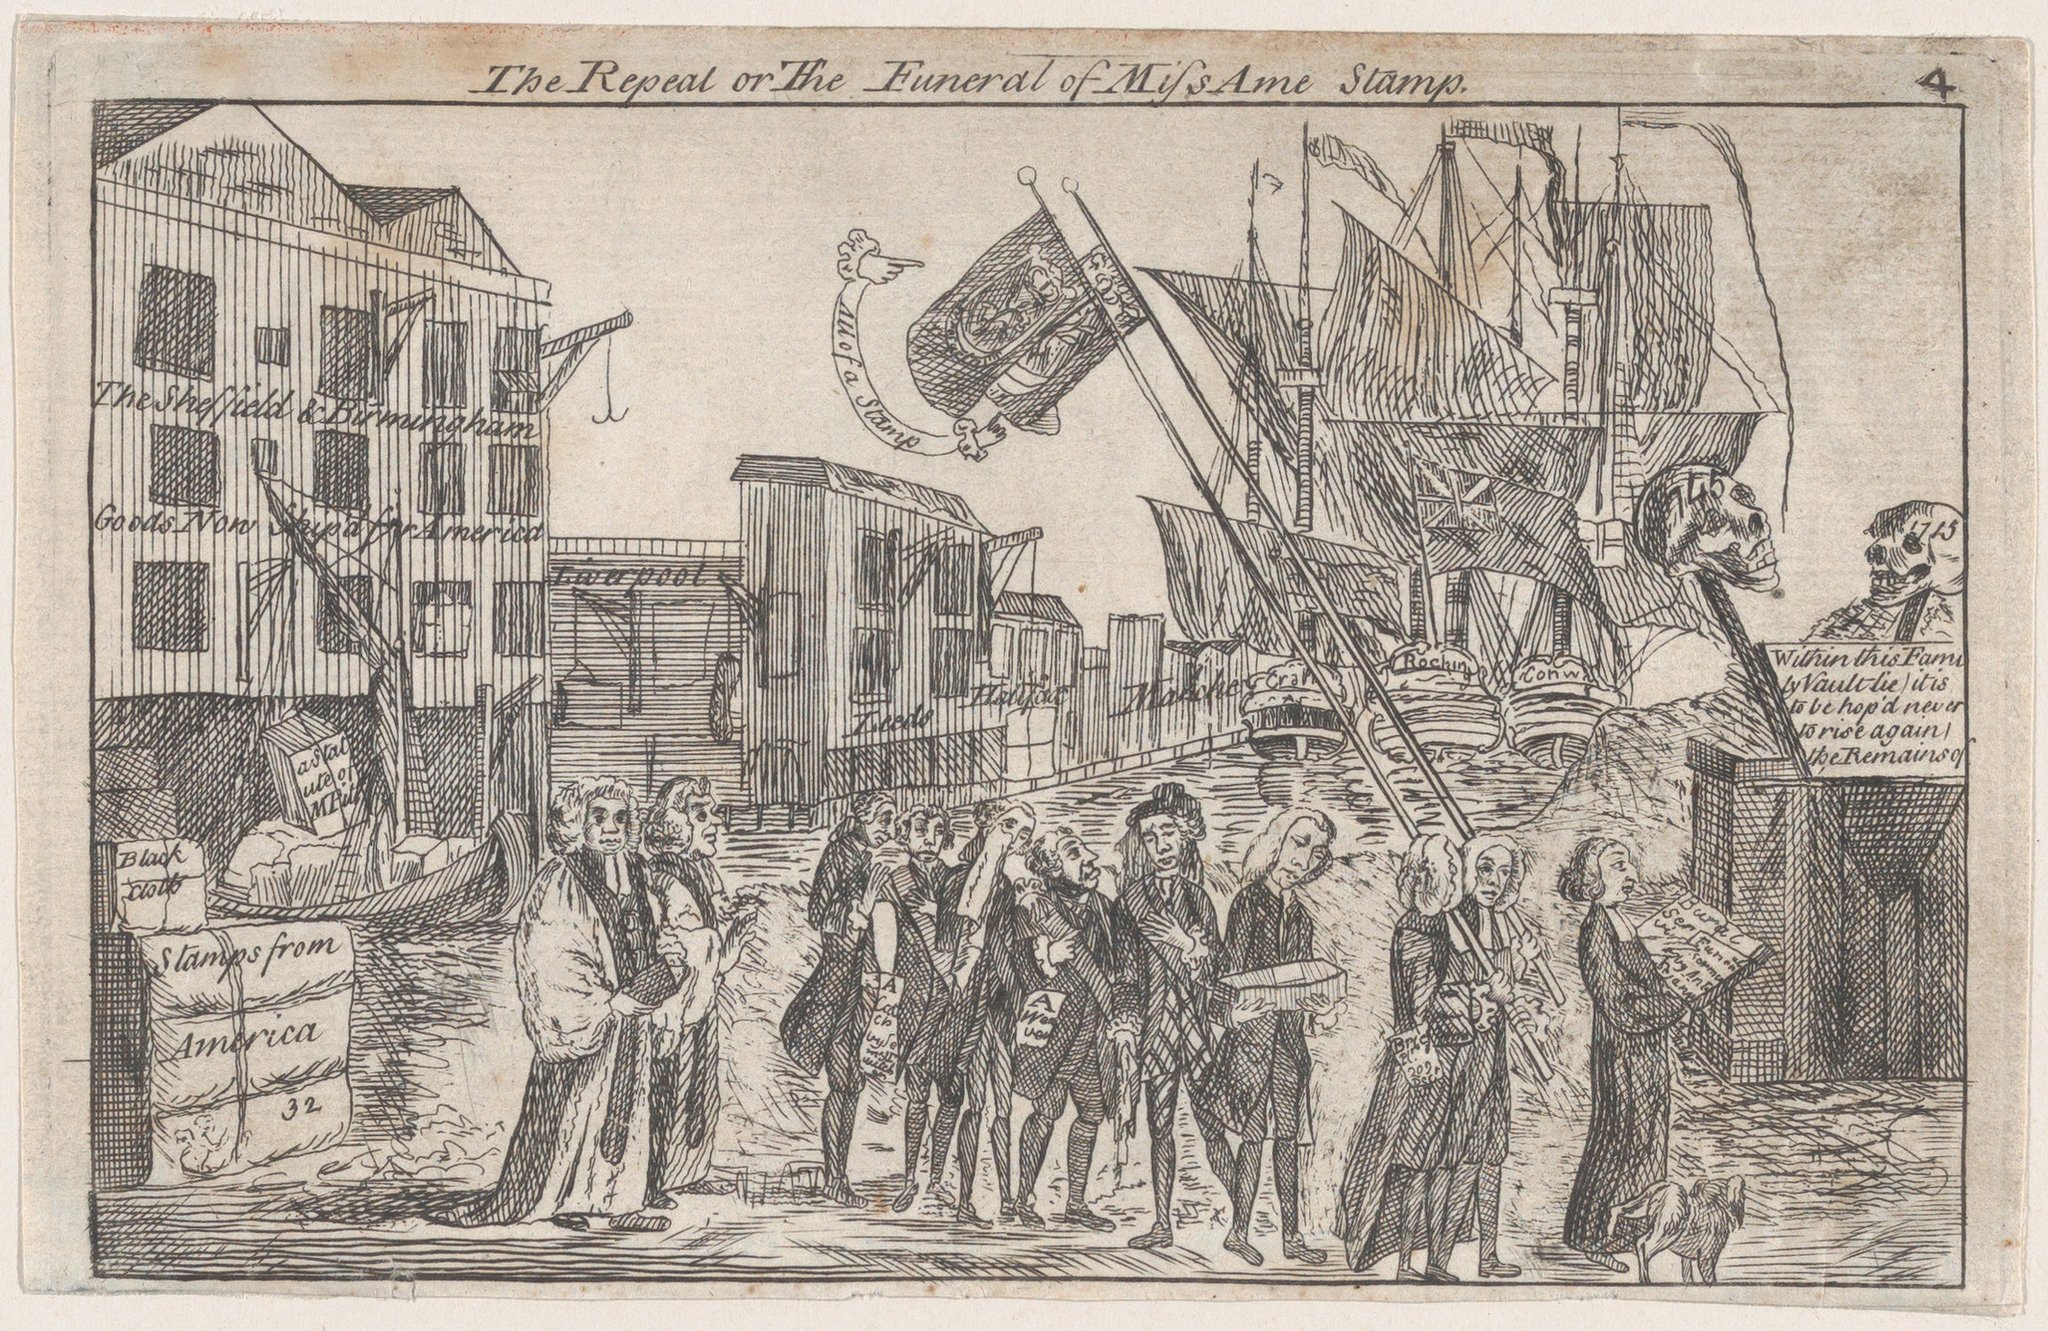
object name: print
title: The Repeal, or the Funeral of Miss Ame Stamp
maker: anonymous, british, 18th century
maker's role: etcher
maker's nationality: british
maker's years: 1700-1800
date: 1766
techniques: etching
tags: satire,american revolution,men,women,boats,politics